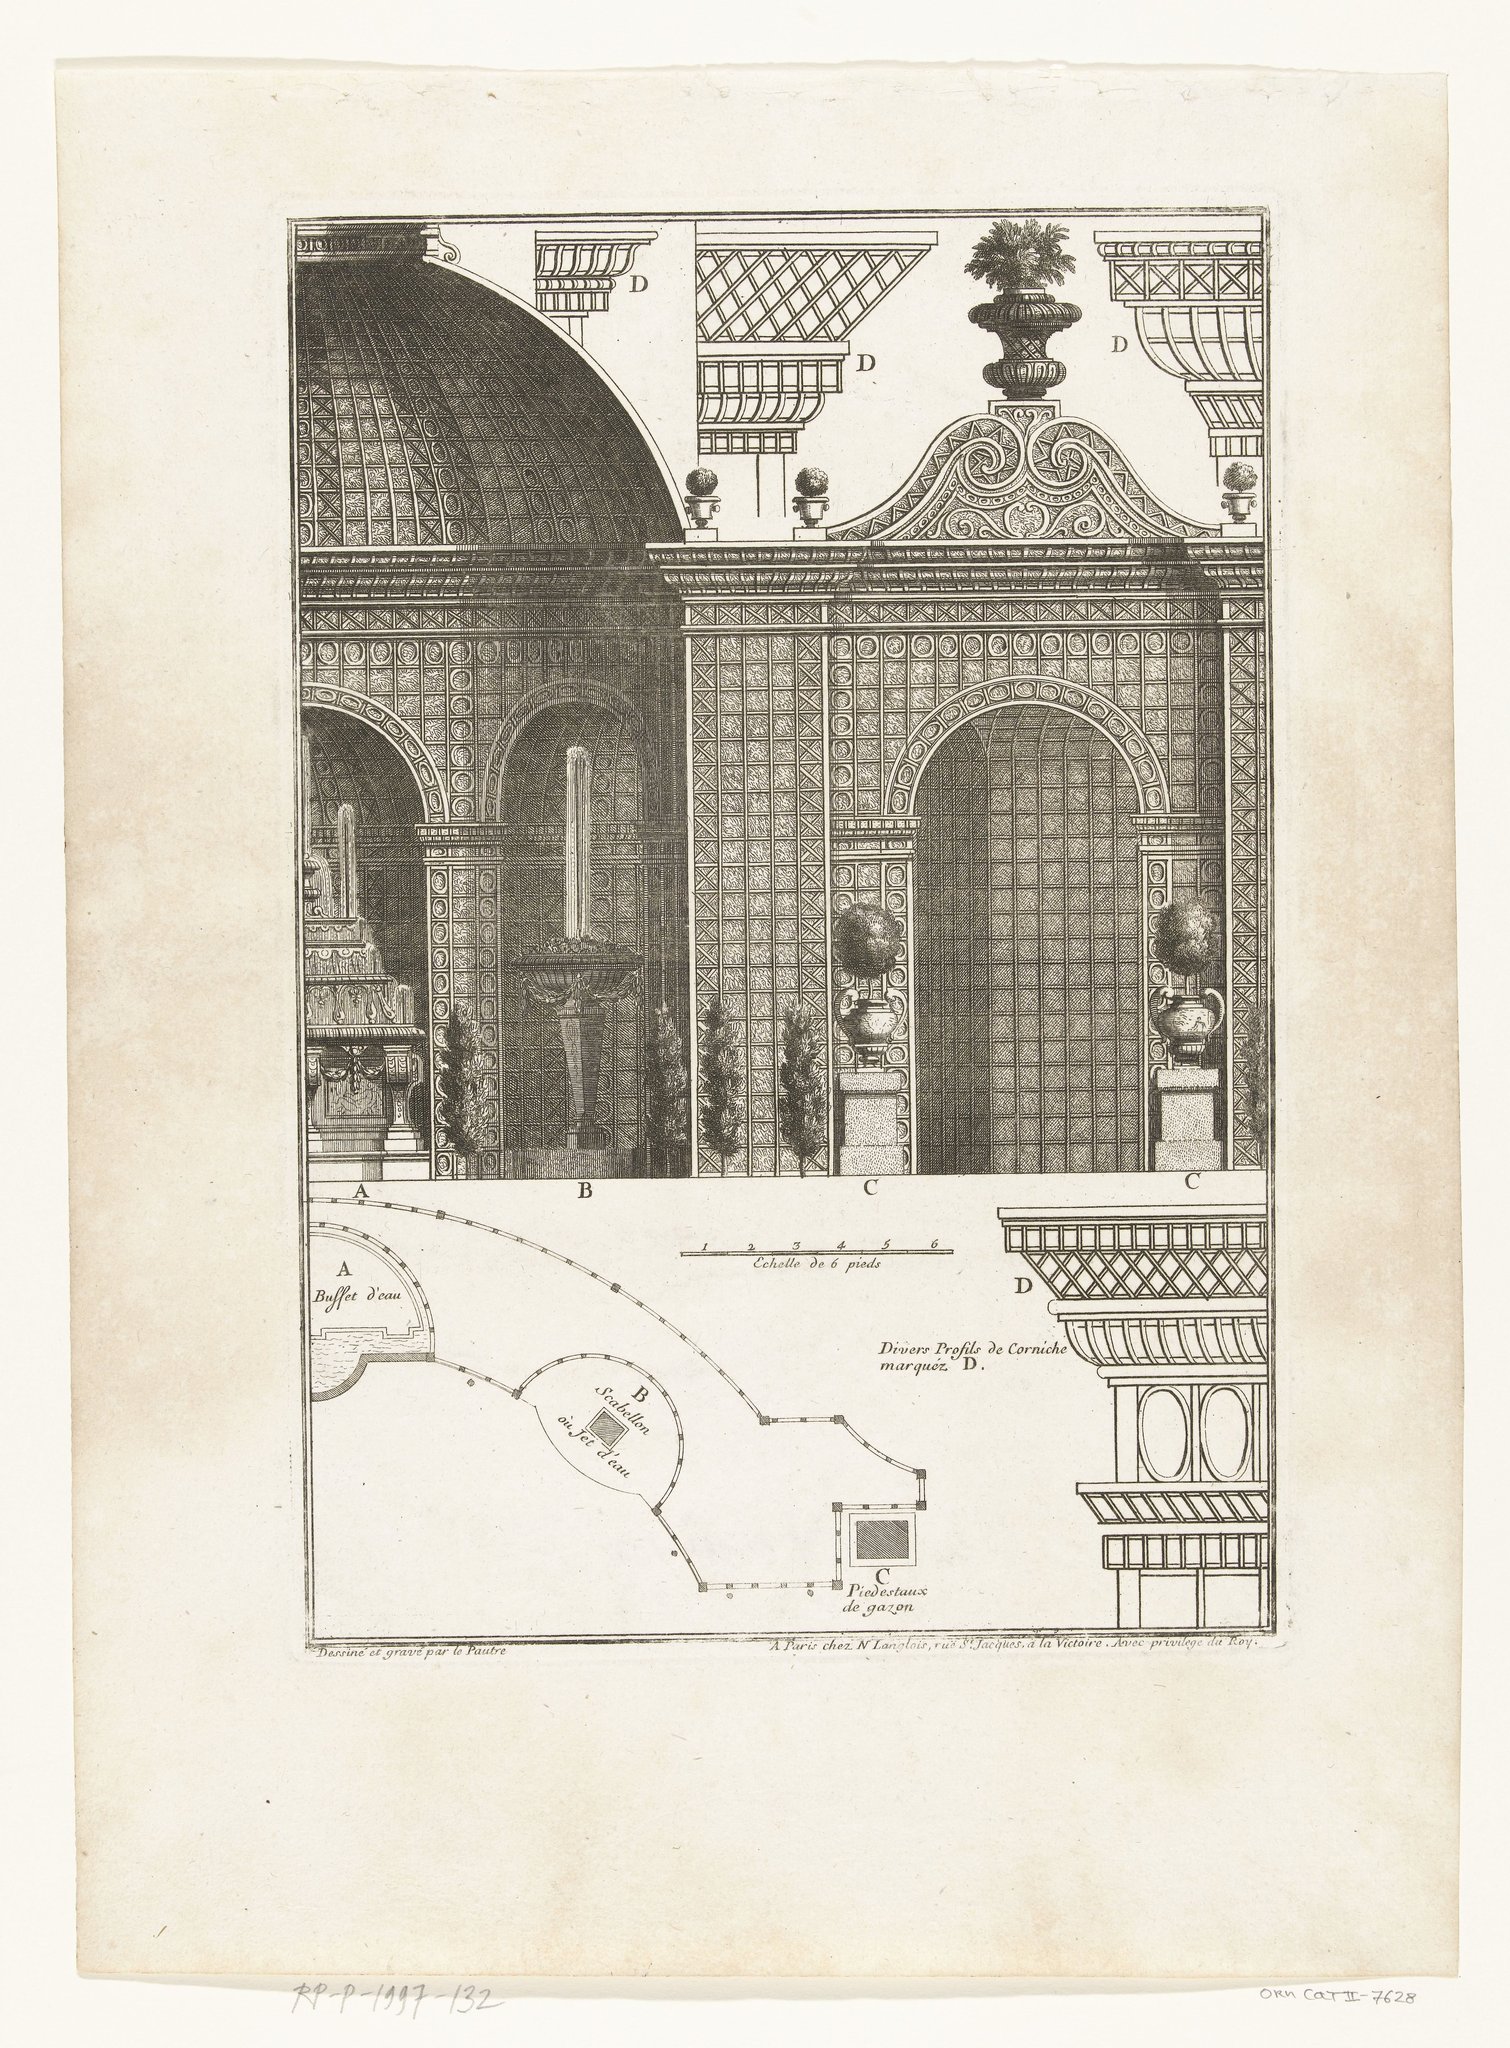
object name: print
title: Latwerkpaviljoens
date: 1670-1703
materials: paper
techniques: etching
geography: paris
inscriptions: inscription: ‘In het midden meetlat met tekst: Echelle de 6 pieds. Naast het kapiteel: Divers Profils de Corniche marquez D. In de plattegrond: A: Buffet d'eau; B: Scabellon ou Jet d'eau; C: Piedestaux de gazon.’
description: Latwerkpaviljoen met fonteinen in nissen, opstand en plan, met vier details van het kroonelement. Uit serie van 6 bladen, tweede editie.